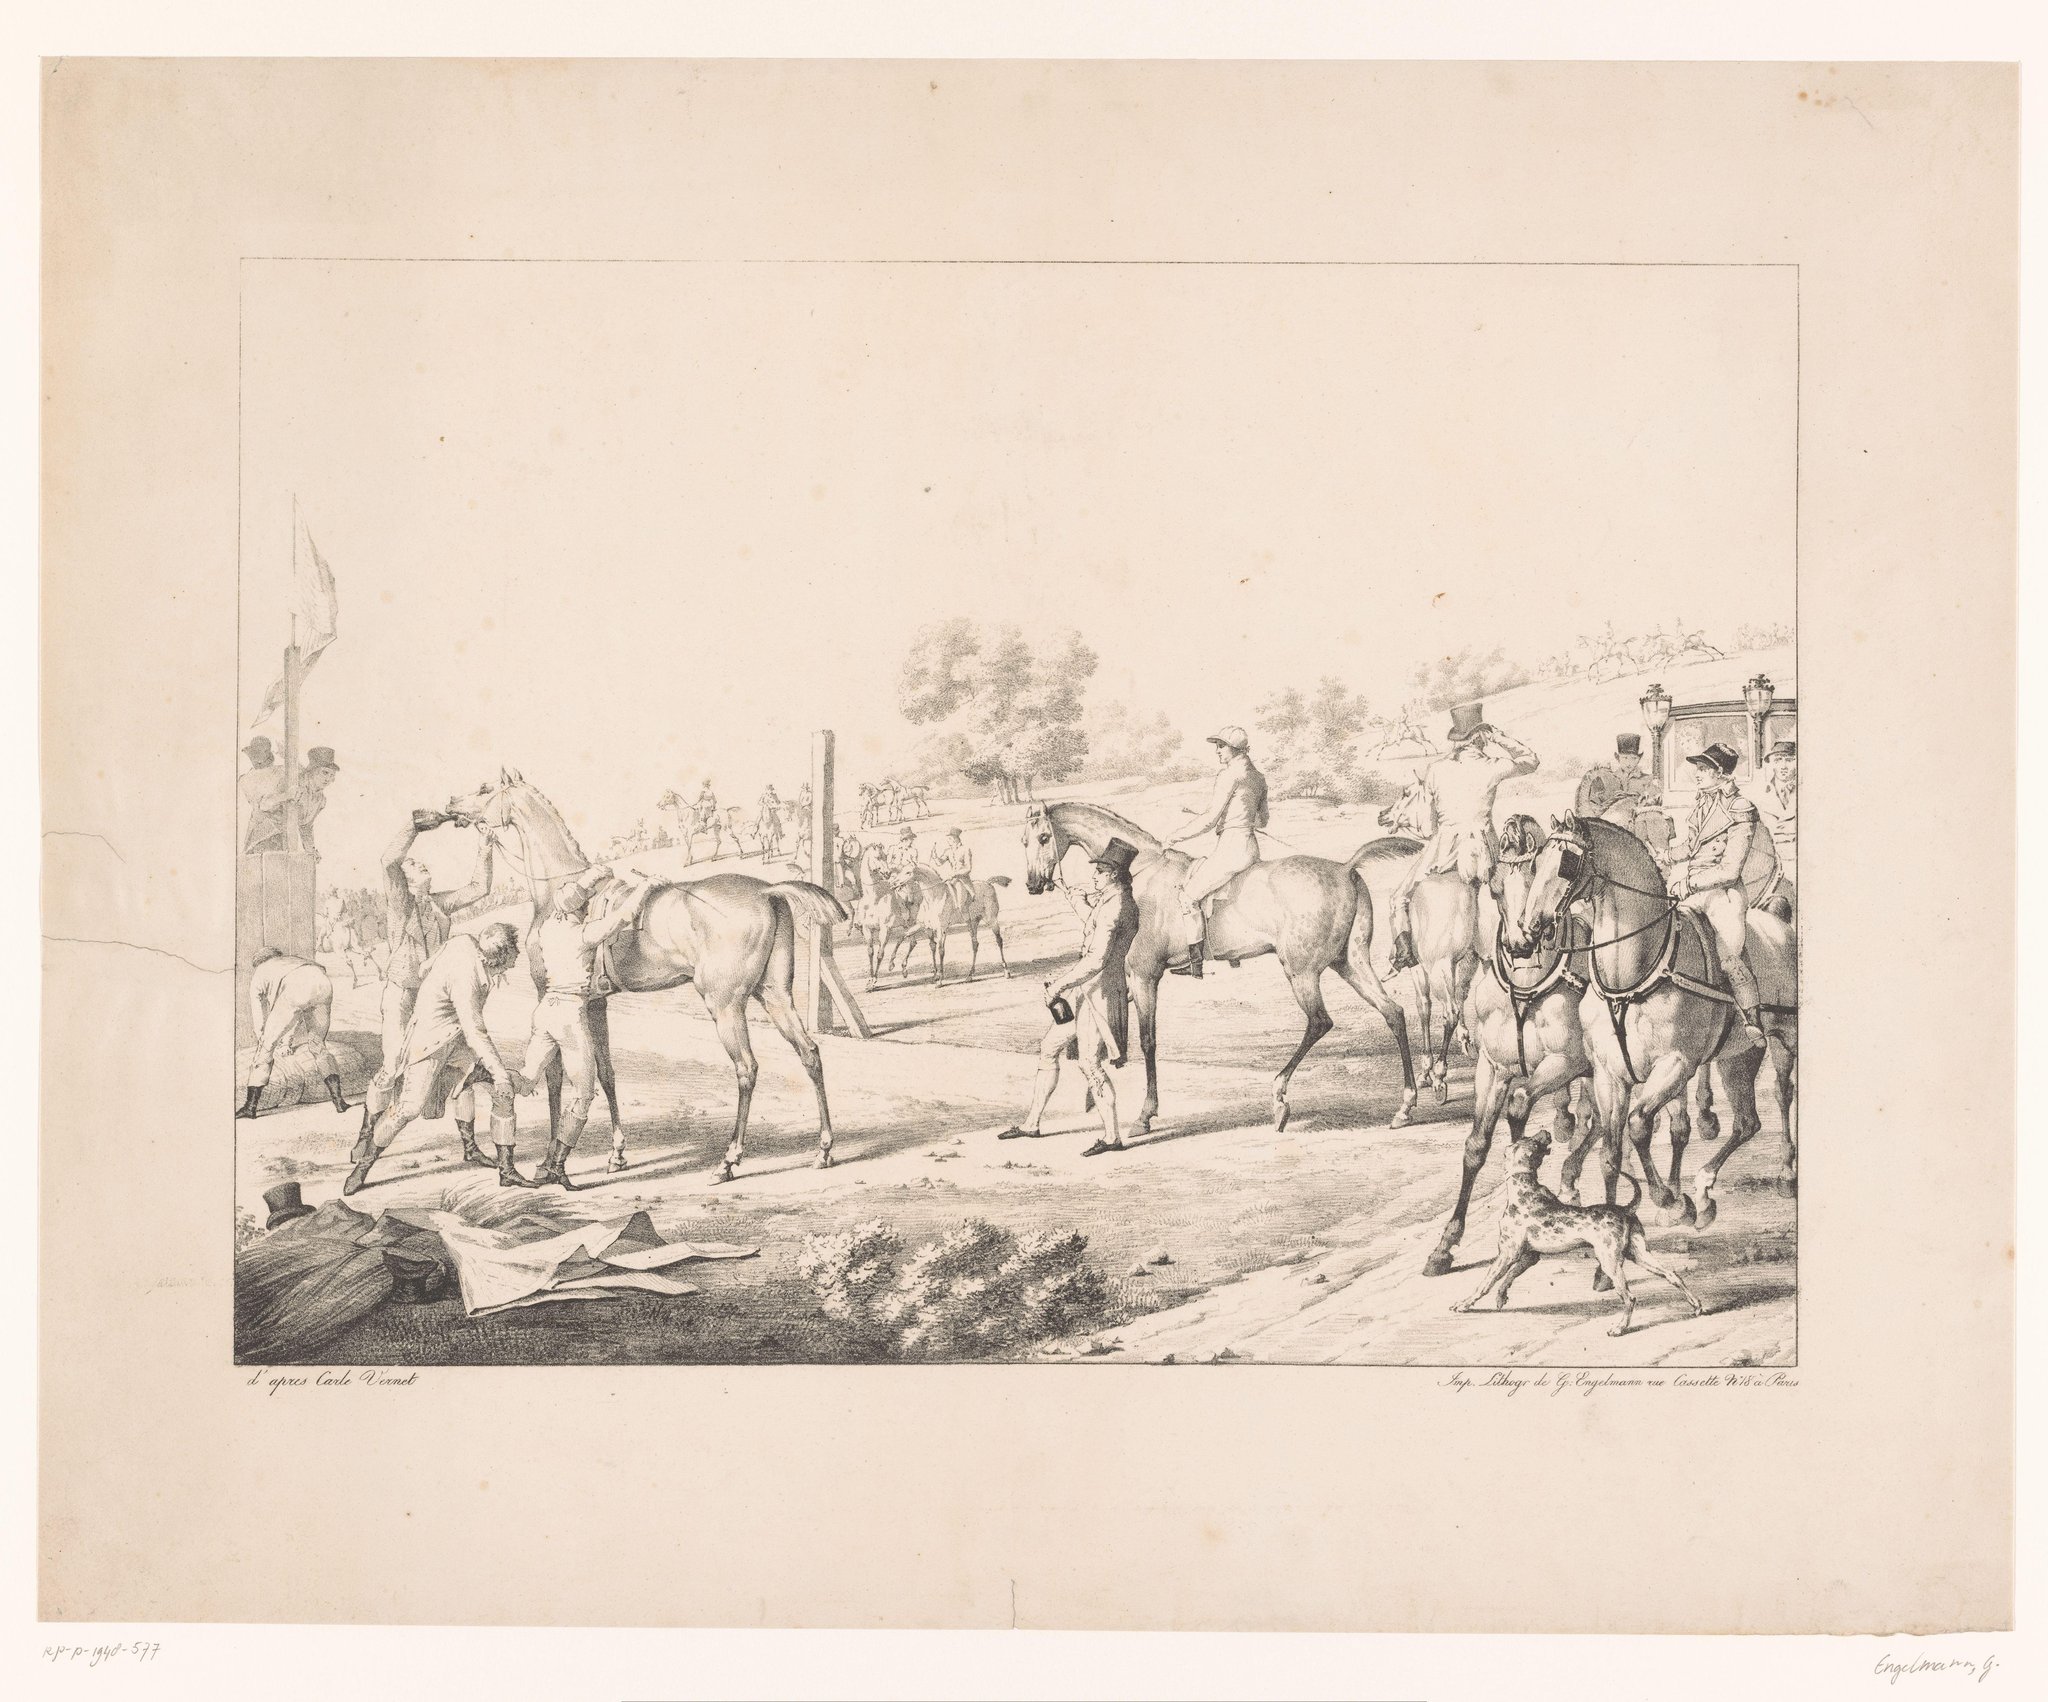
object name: print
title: Voorbereiding van de paardenrennen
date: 1816-1839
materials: paper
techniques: lithograph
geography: paris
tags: horse-racing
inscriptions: collector's mark: Lugt 2228a